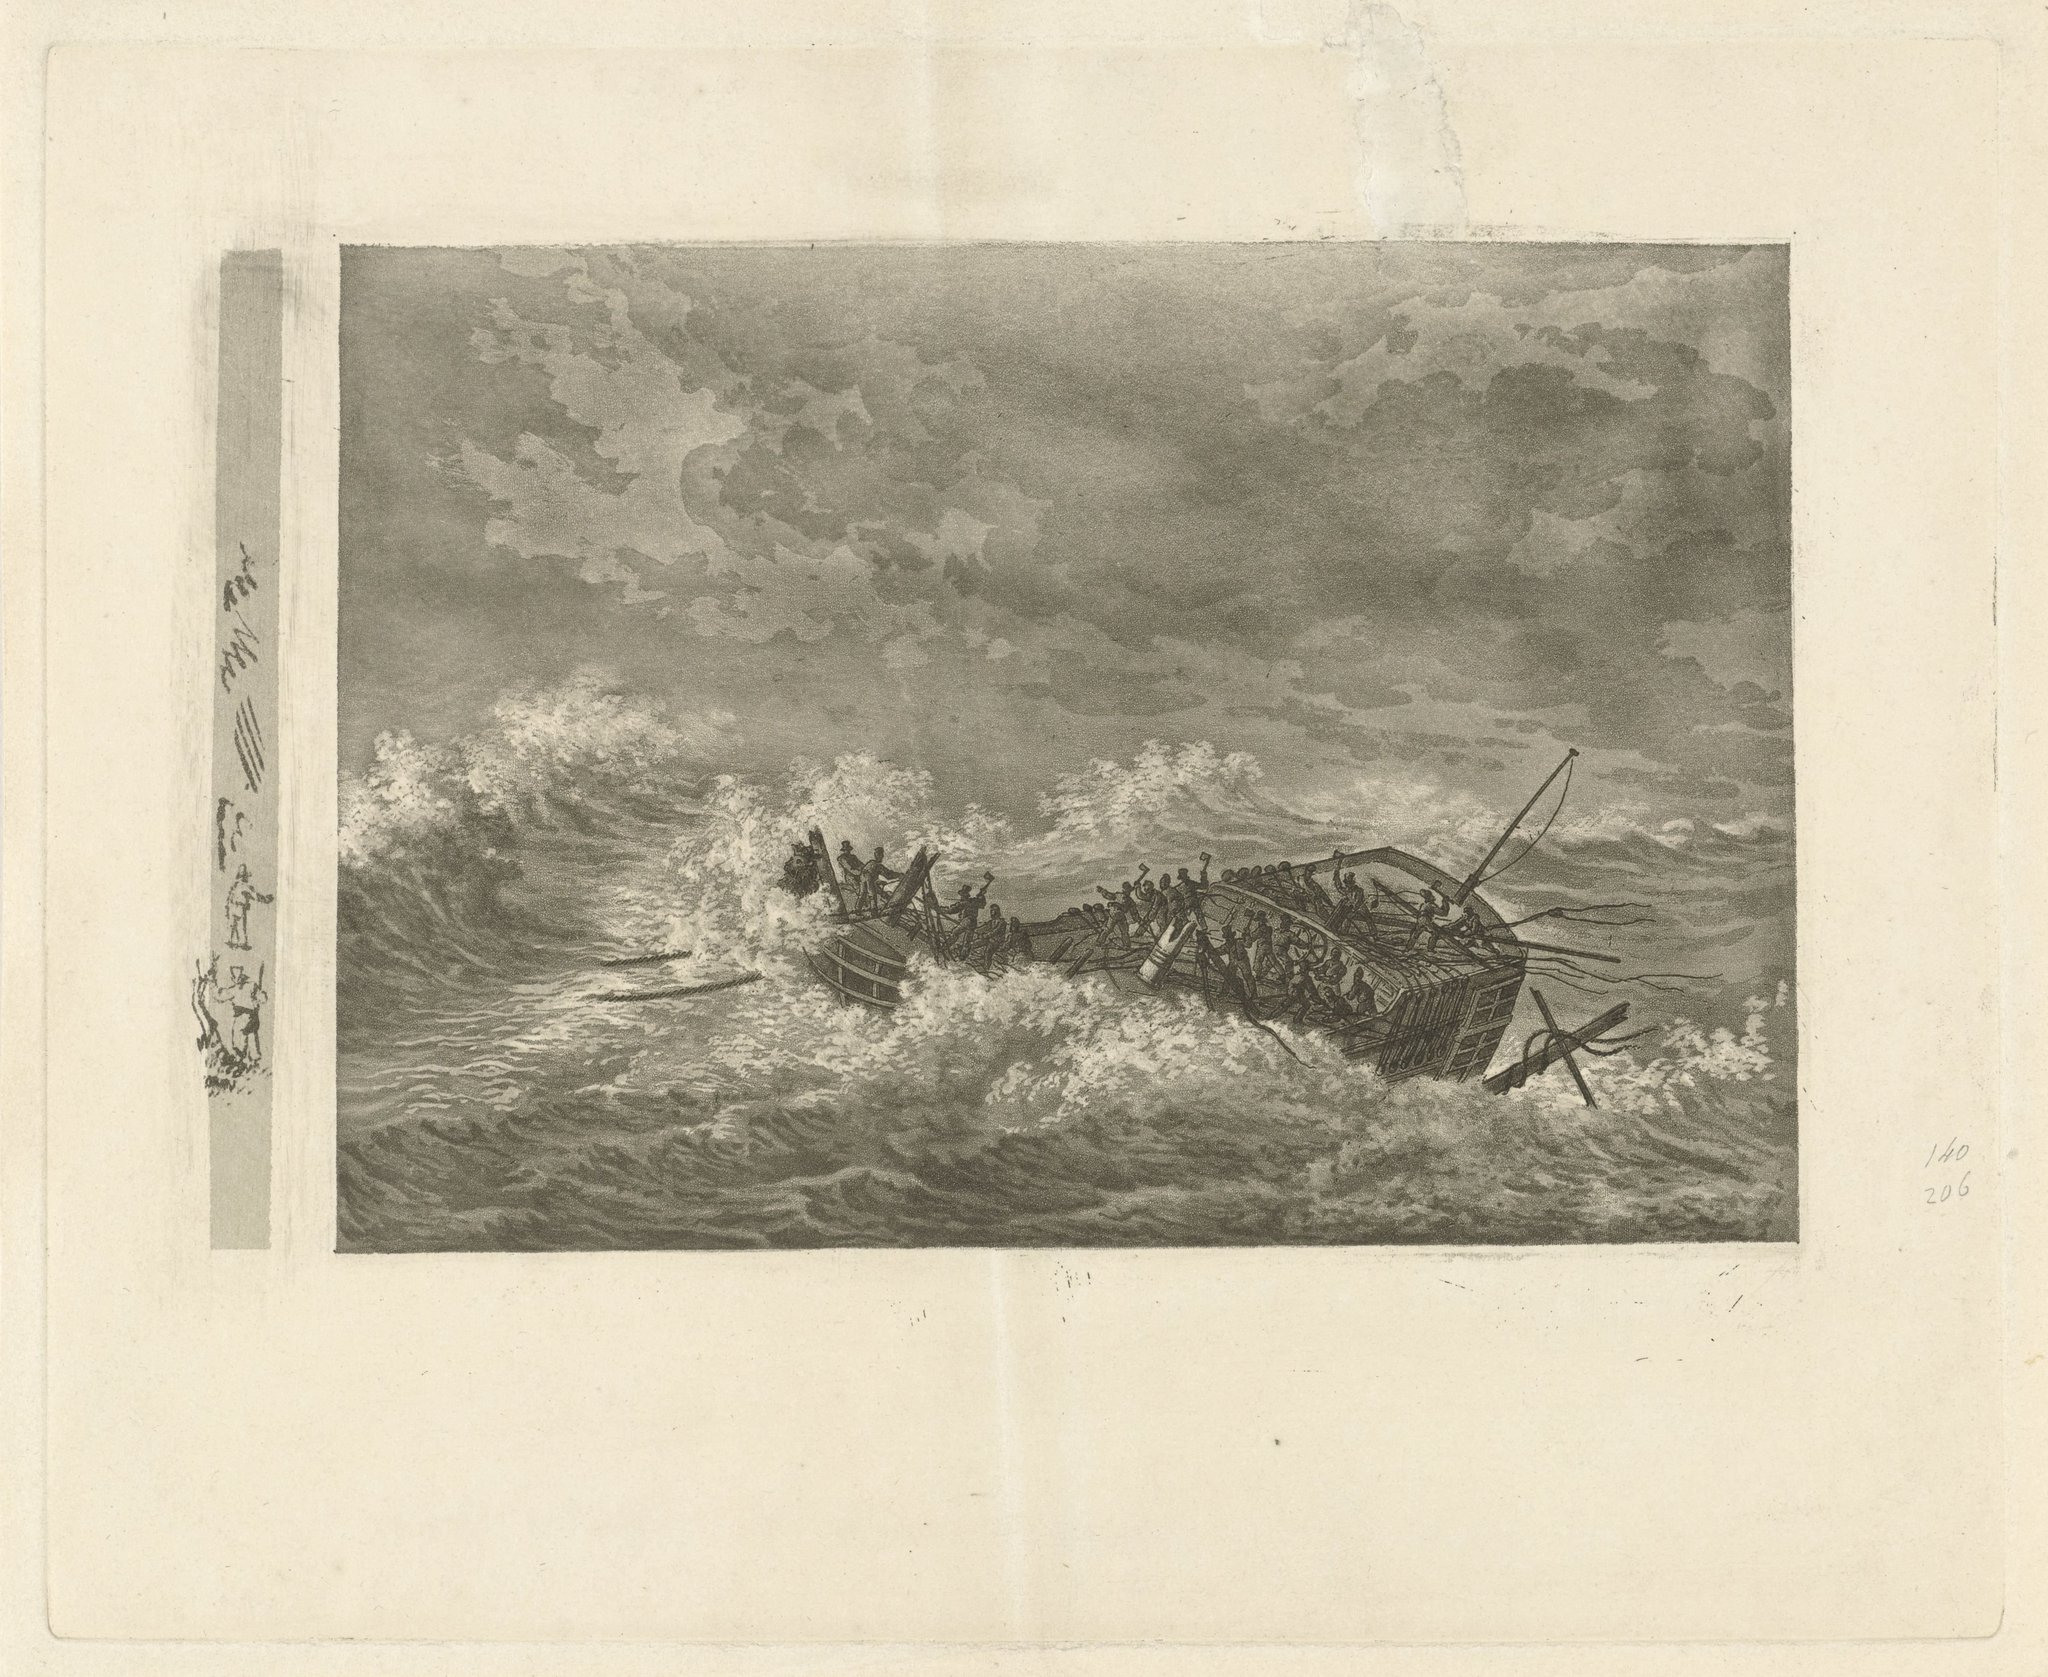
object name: print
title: Stormachtige zee met zinkend schip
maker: françois joseph pfeiffer (ii)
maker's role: draughtsman, print maker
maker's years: 1778-1835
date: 1793-1835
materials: paper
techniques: aquatint, etching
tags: shipwreck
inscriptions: collector's mark: Lugt 2228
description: Stormachtige zee met een zinkend schip en opvarenden die de masten van het schip slaan. Links op het blad studies van figuren en lijnen.